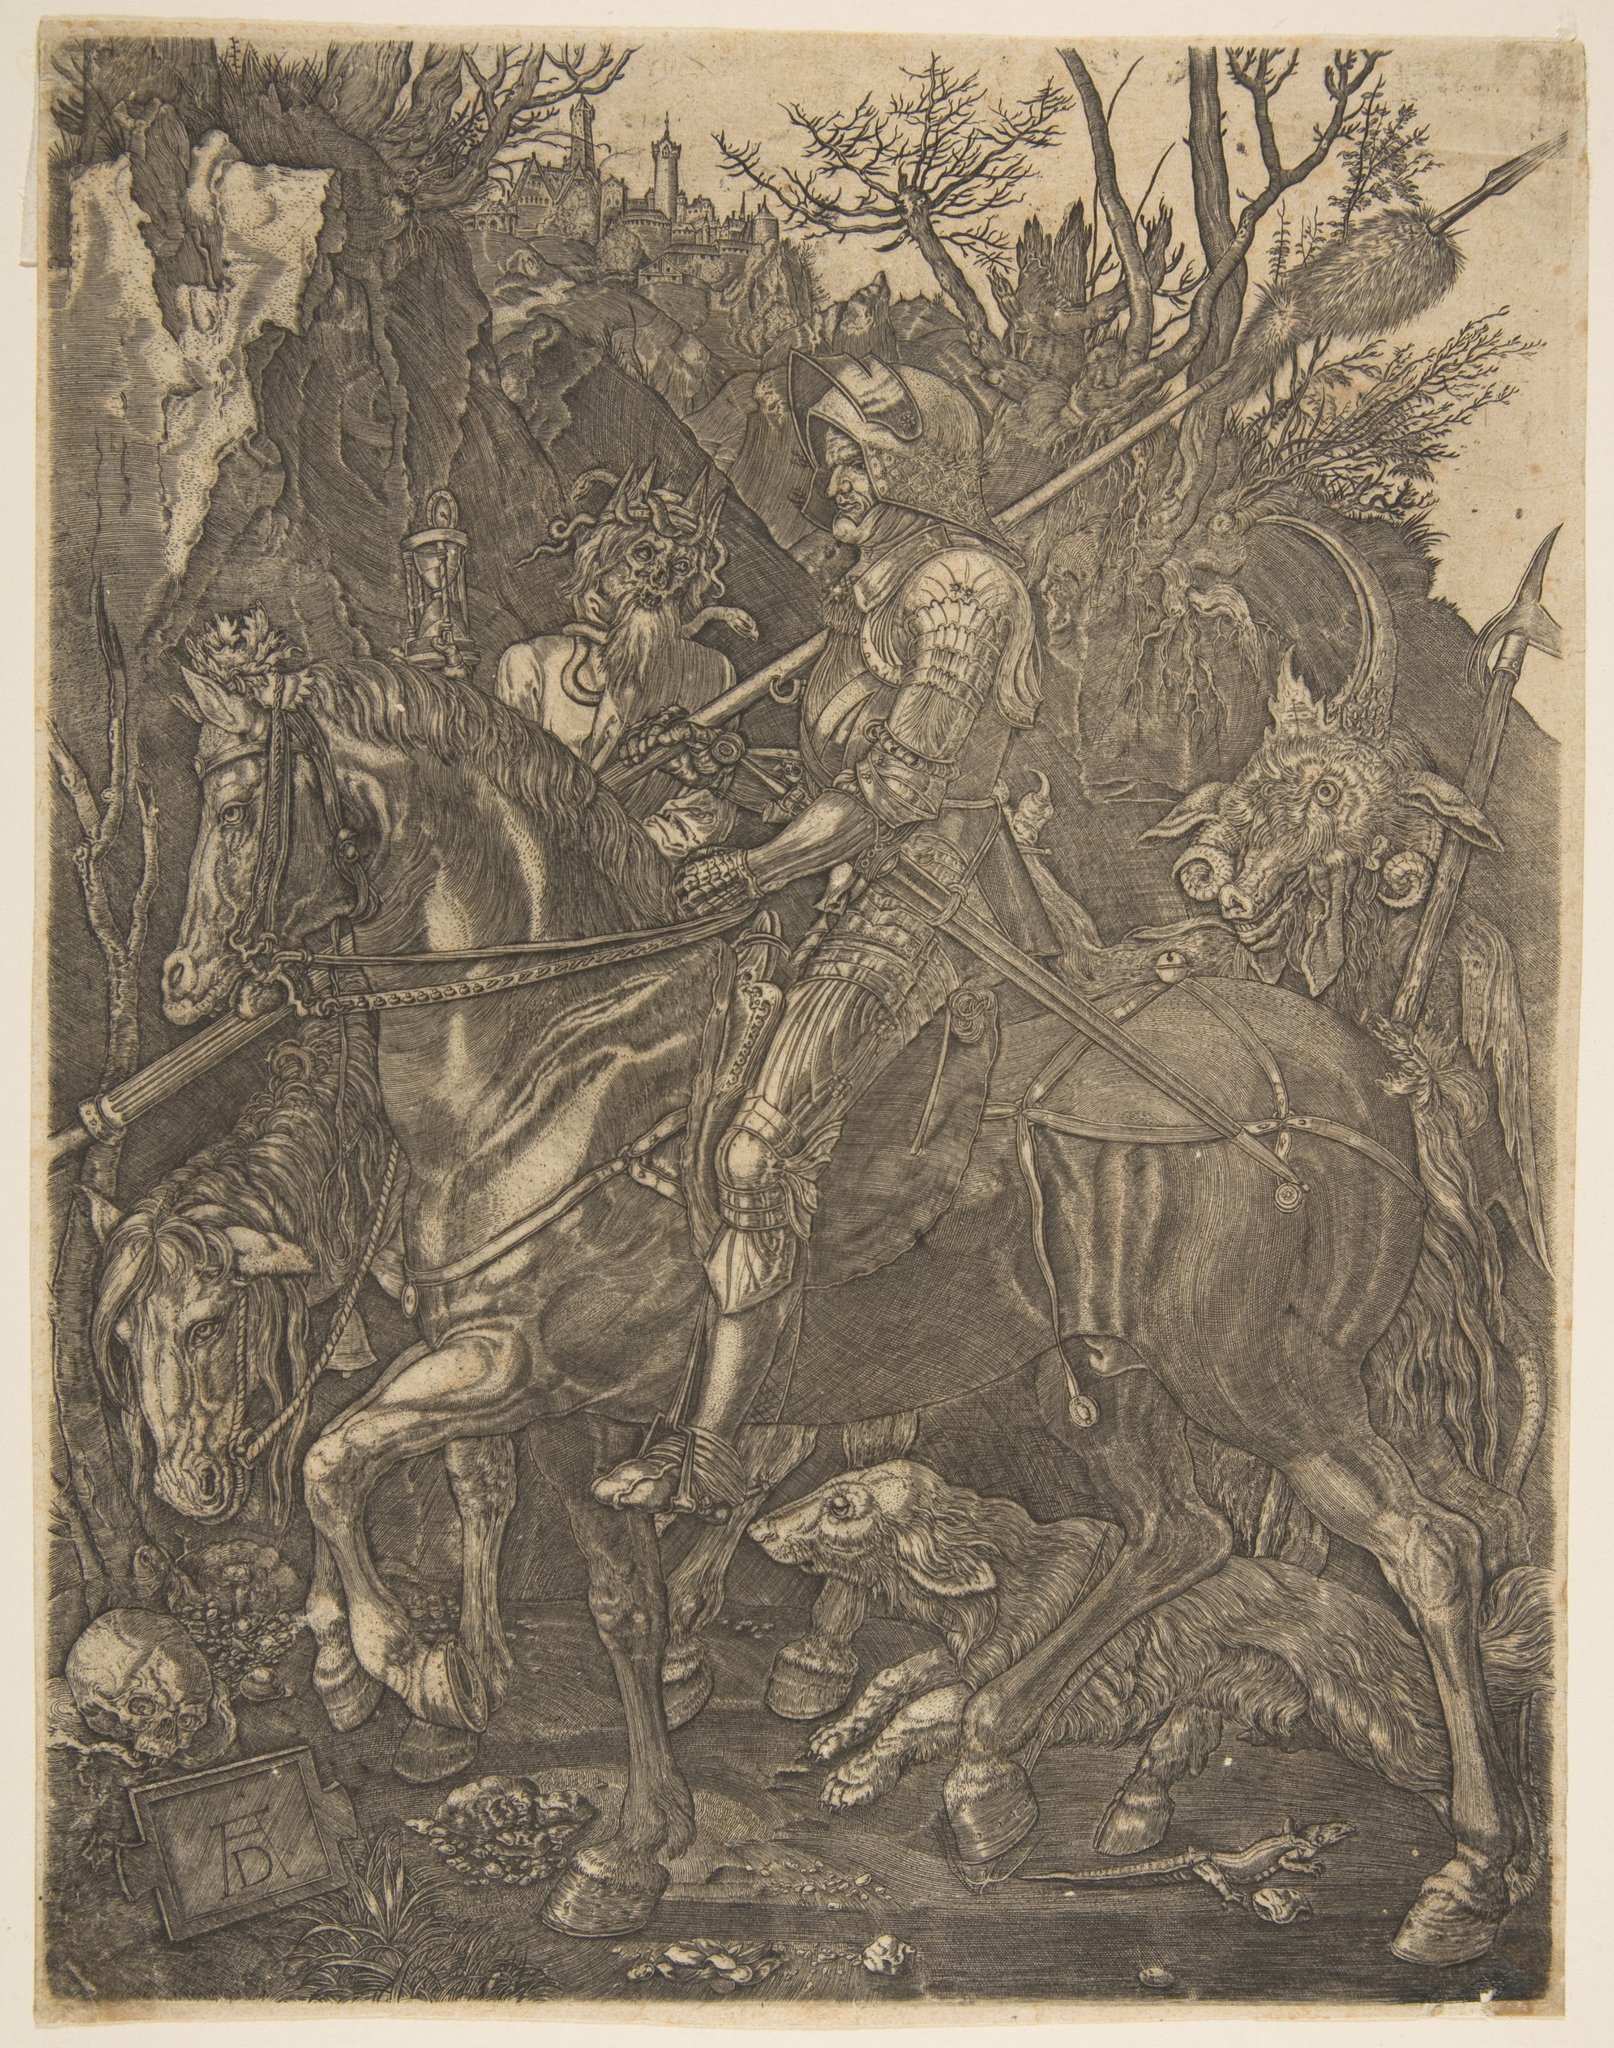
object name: print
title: Knight, Death, and the Devil (copy)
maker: albrecht dürer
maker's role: artist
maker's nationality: german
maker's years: 1471-1528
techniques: engraving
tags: dogs,horses,devil,knights